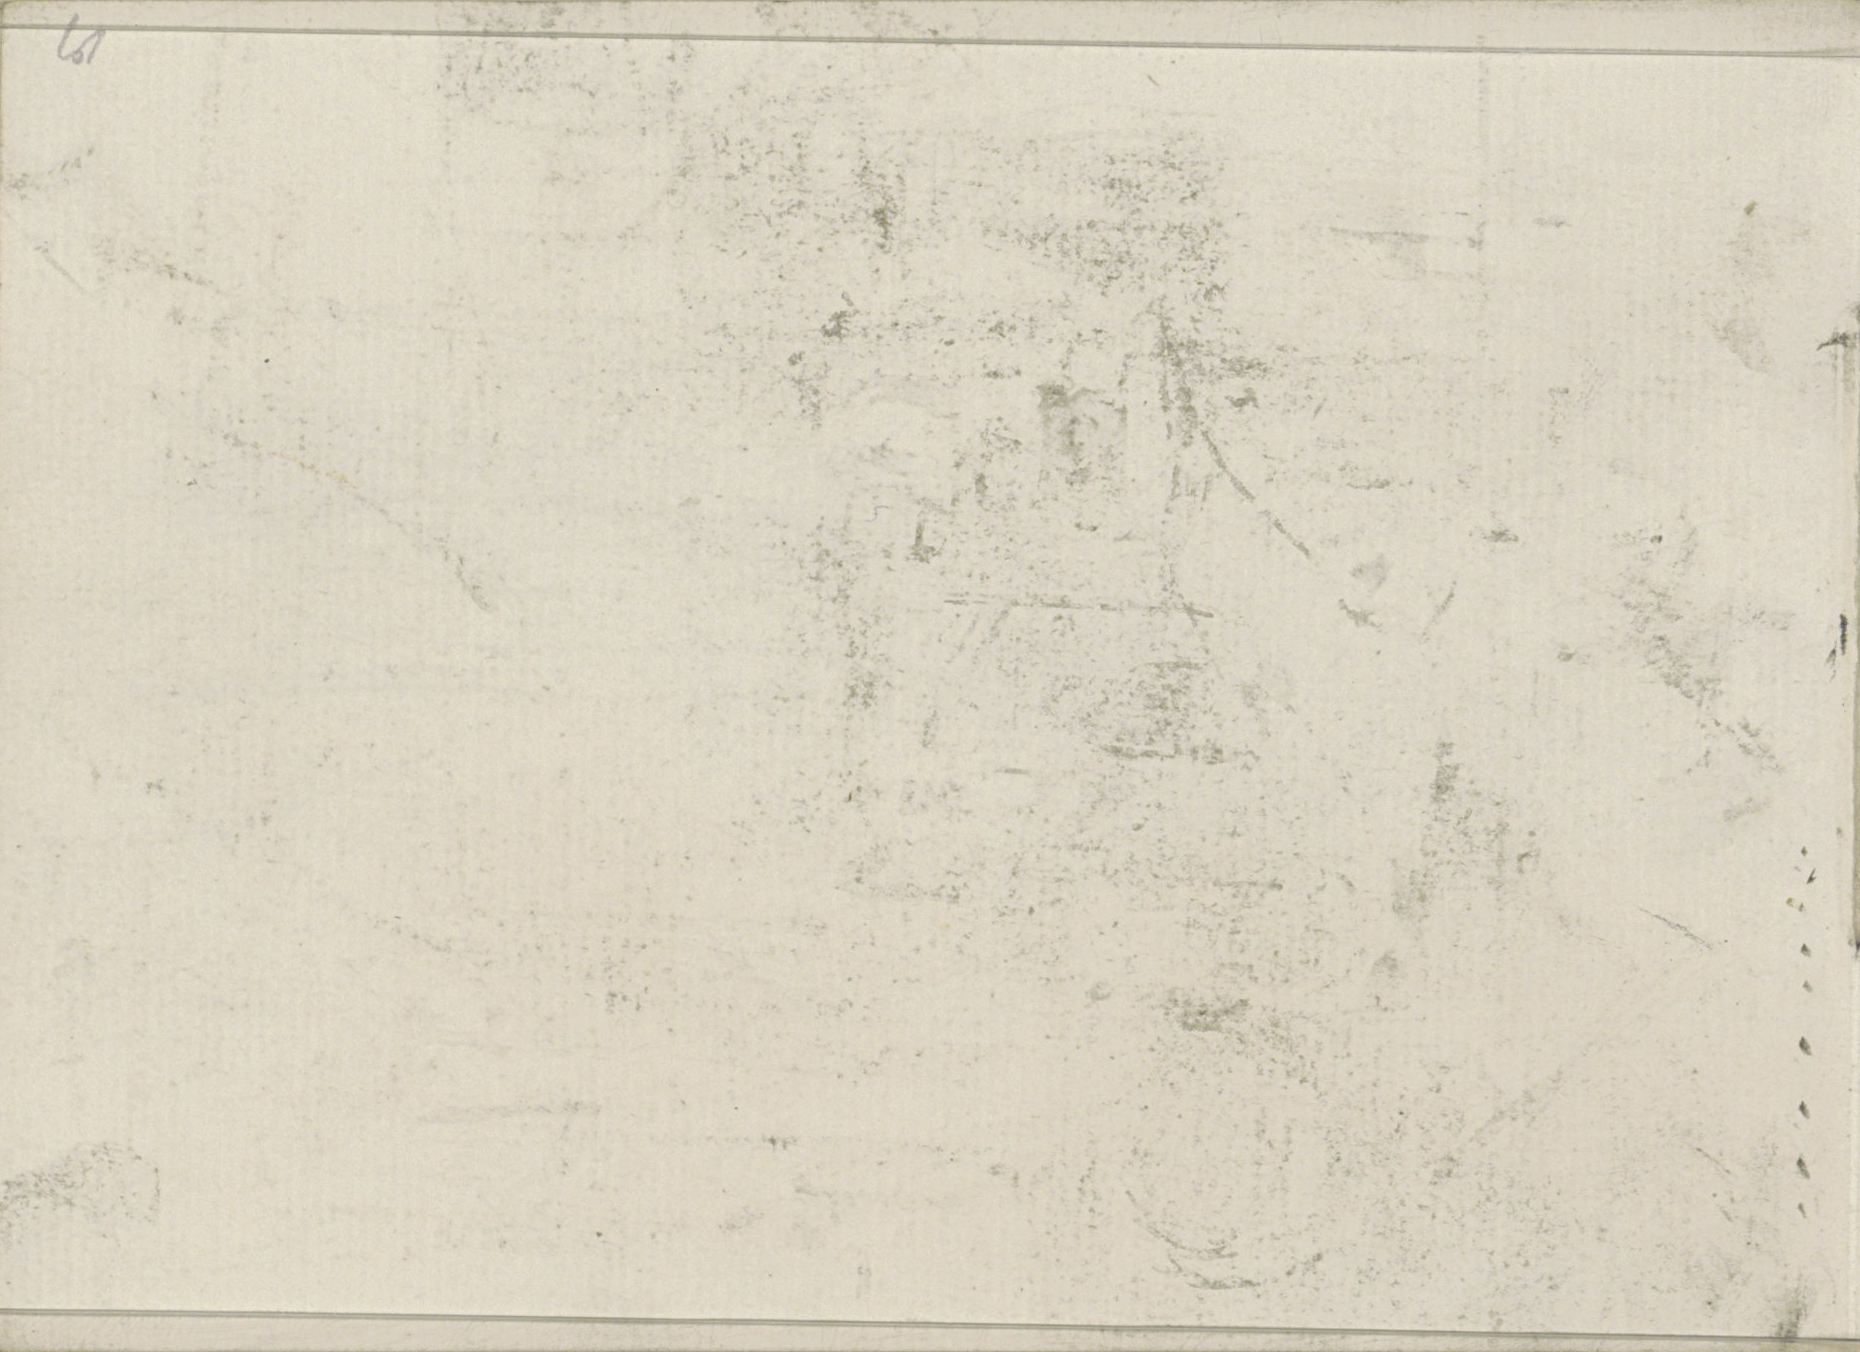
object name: sketchbook leaf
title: Abklatsch van de krijttekening op blad 4 recto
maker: isaac israels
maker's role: draughtsman, painter, print maker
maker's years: 1865-1934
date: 1875-1934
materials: paper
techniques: printmaking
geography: amsterdam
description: Blad 3 verso uit schetsboek XXXI met 10 bladen.